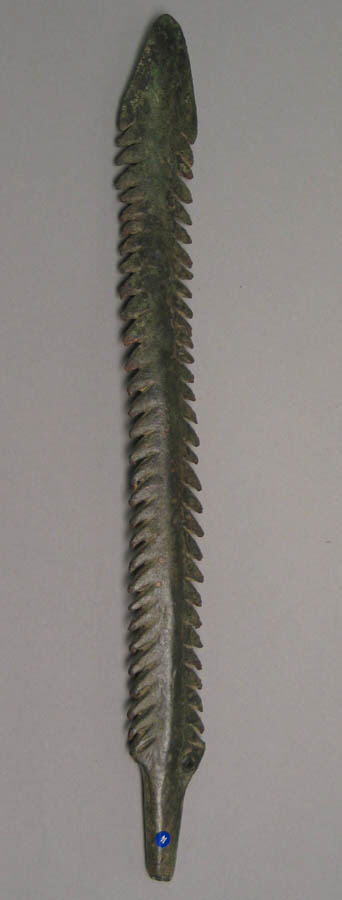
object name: harpoon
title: Serrated Harpoon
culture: indian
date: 1500-500 BCE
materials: copper